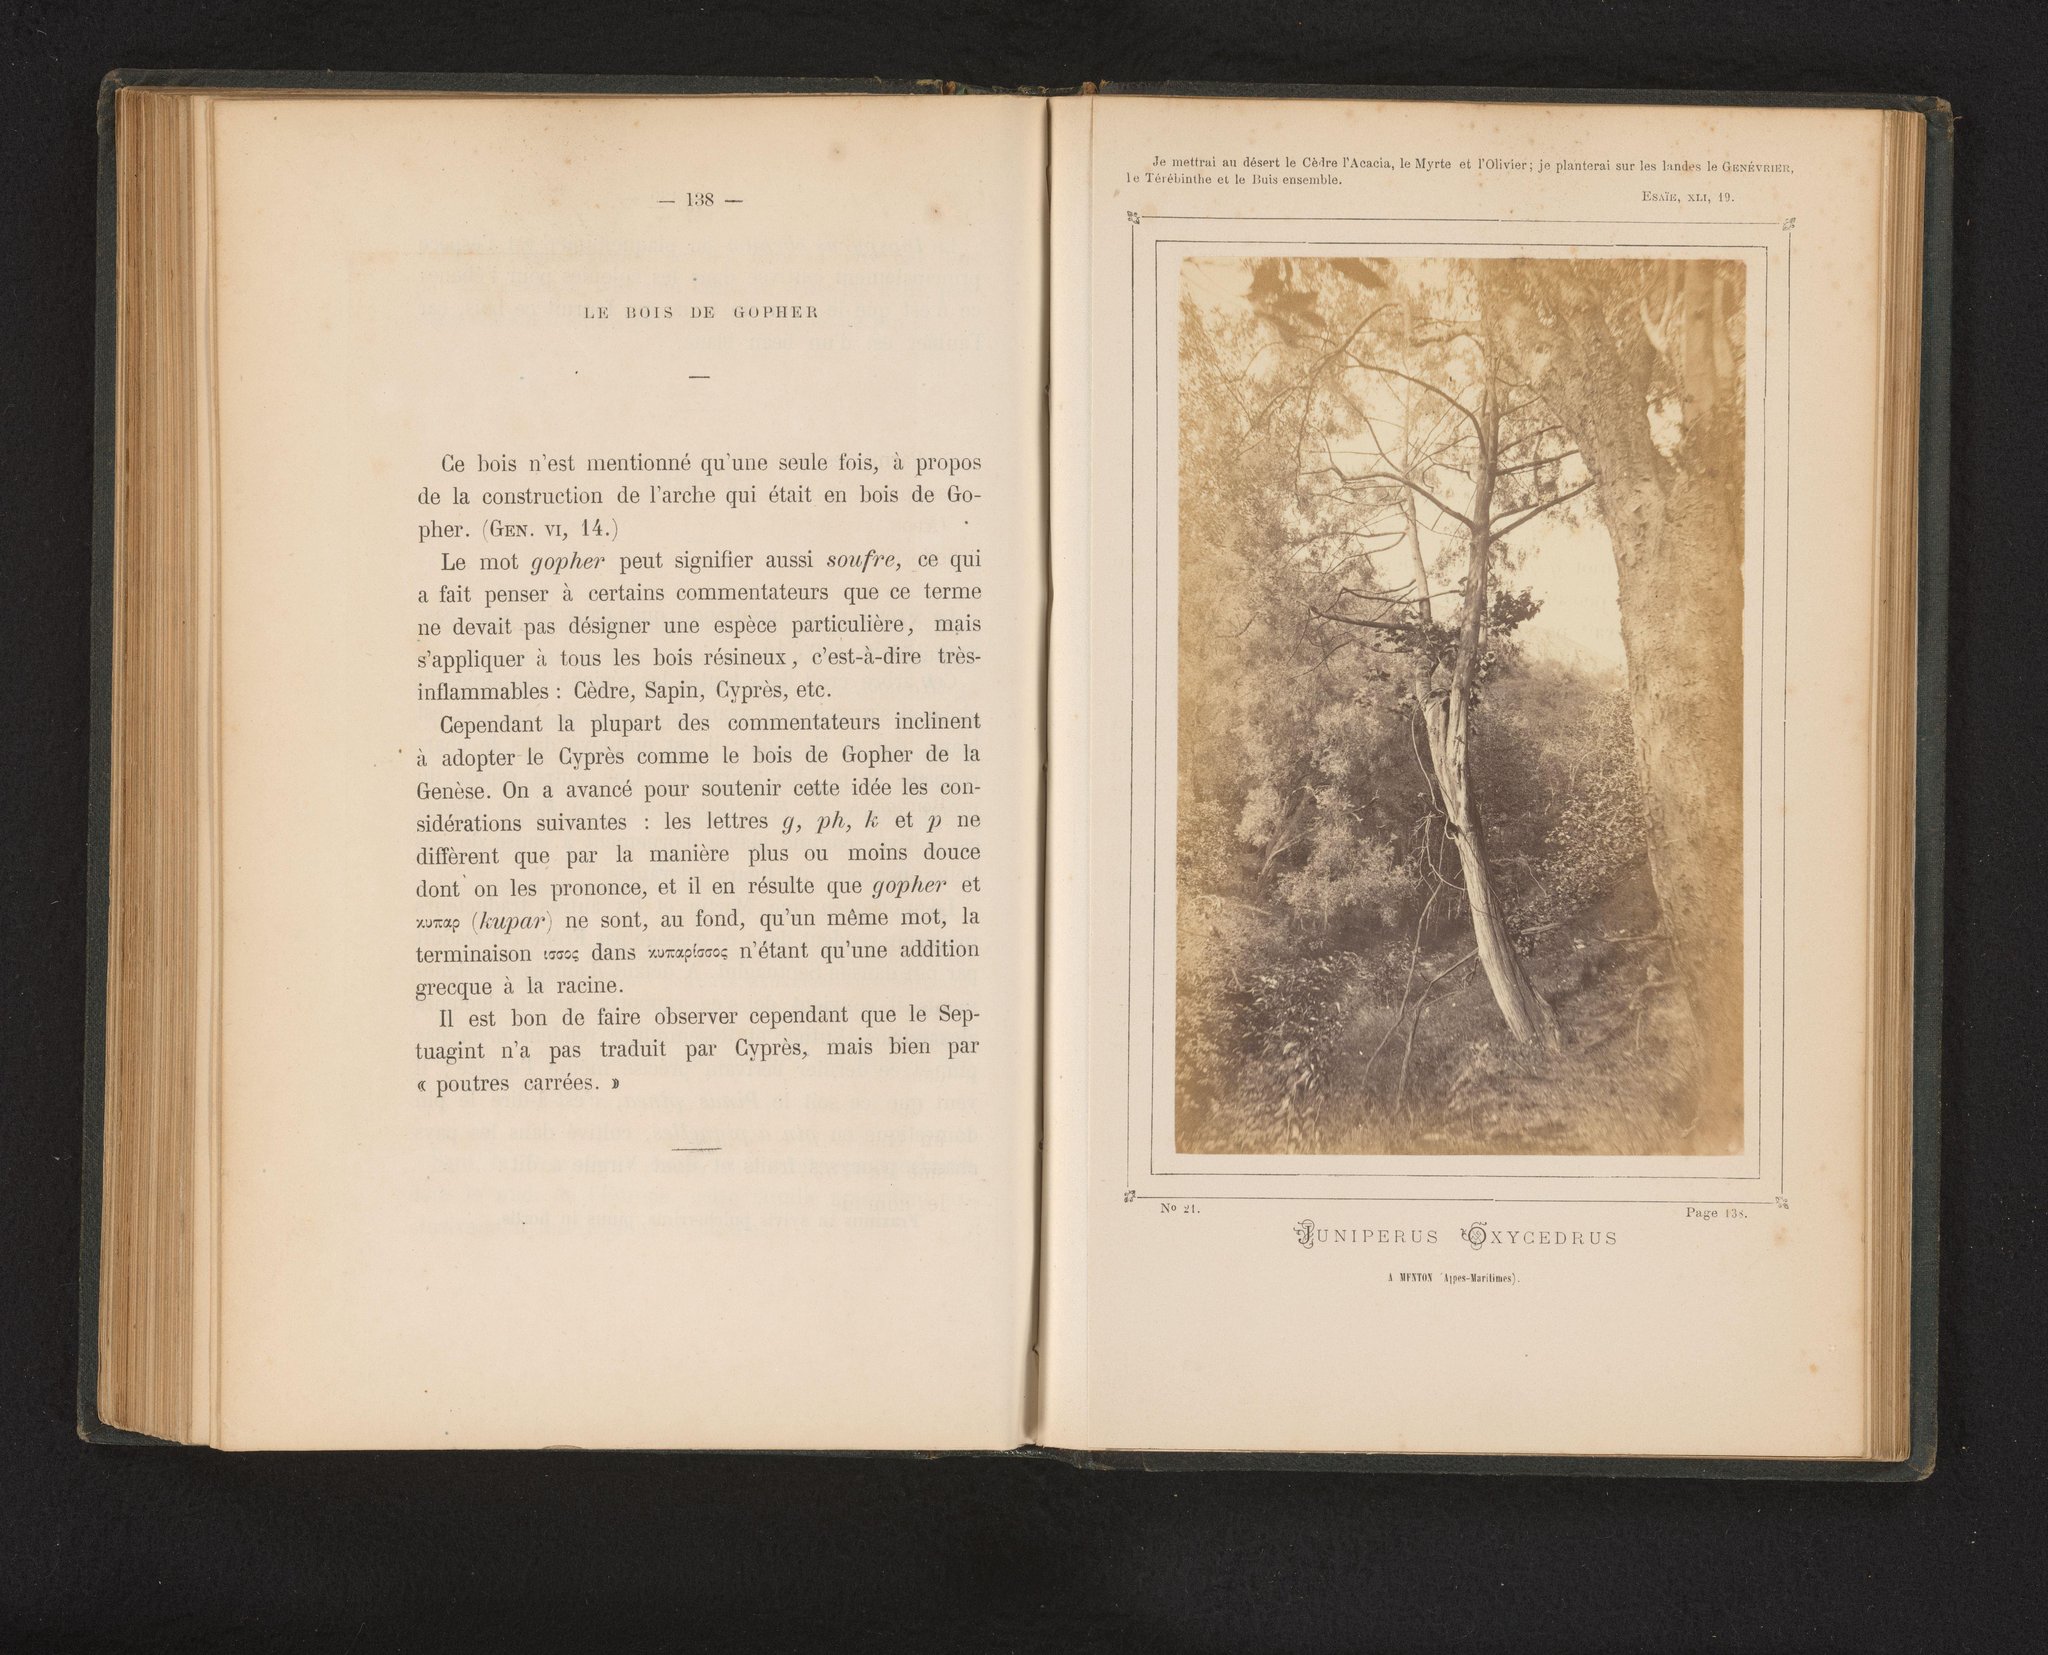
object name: photograph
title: Juniperus Oxycedrus. A Menton (Alpes-Maritimes)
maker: jean walburg de bray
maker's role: fotograaf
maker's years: 1839-1901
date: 1866-1871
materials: paper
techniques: albumen print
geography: menton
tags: trees: cypress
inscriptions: inscription: ‘Page 138.’, inscription: ‘Je mettrai au désert le Cèdre l'Acacia, le Myrte et l'Olivier; je planterai sur les landes le GENÉVRIER,/ le Térébinthe et le Buis ensemble./ ESAÏE, XII, 19.’, number: ‘No 21.’